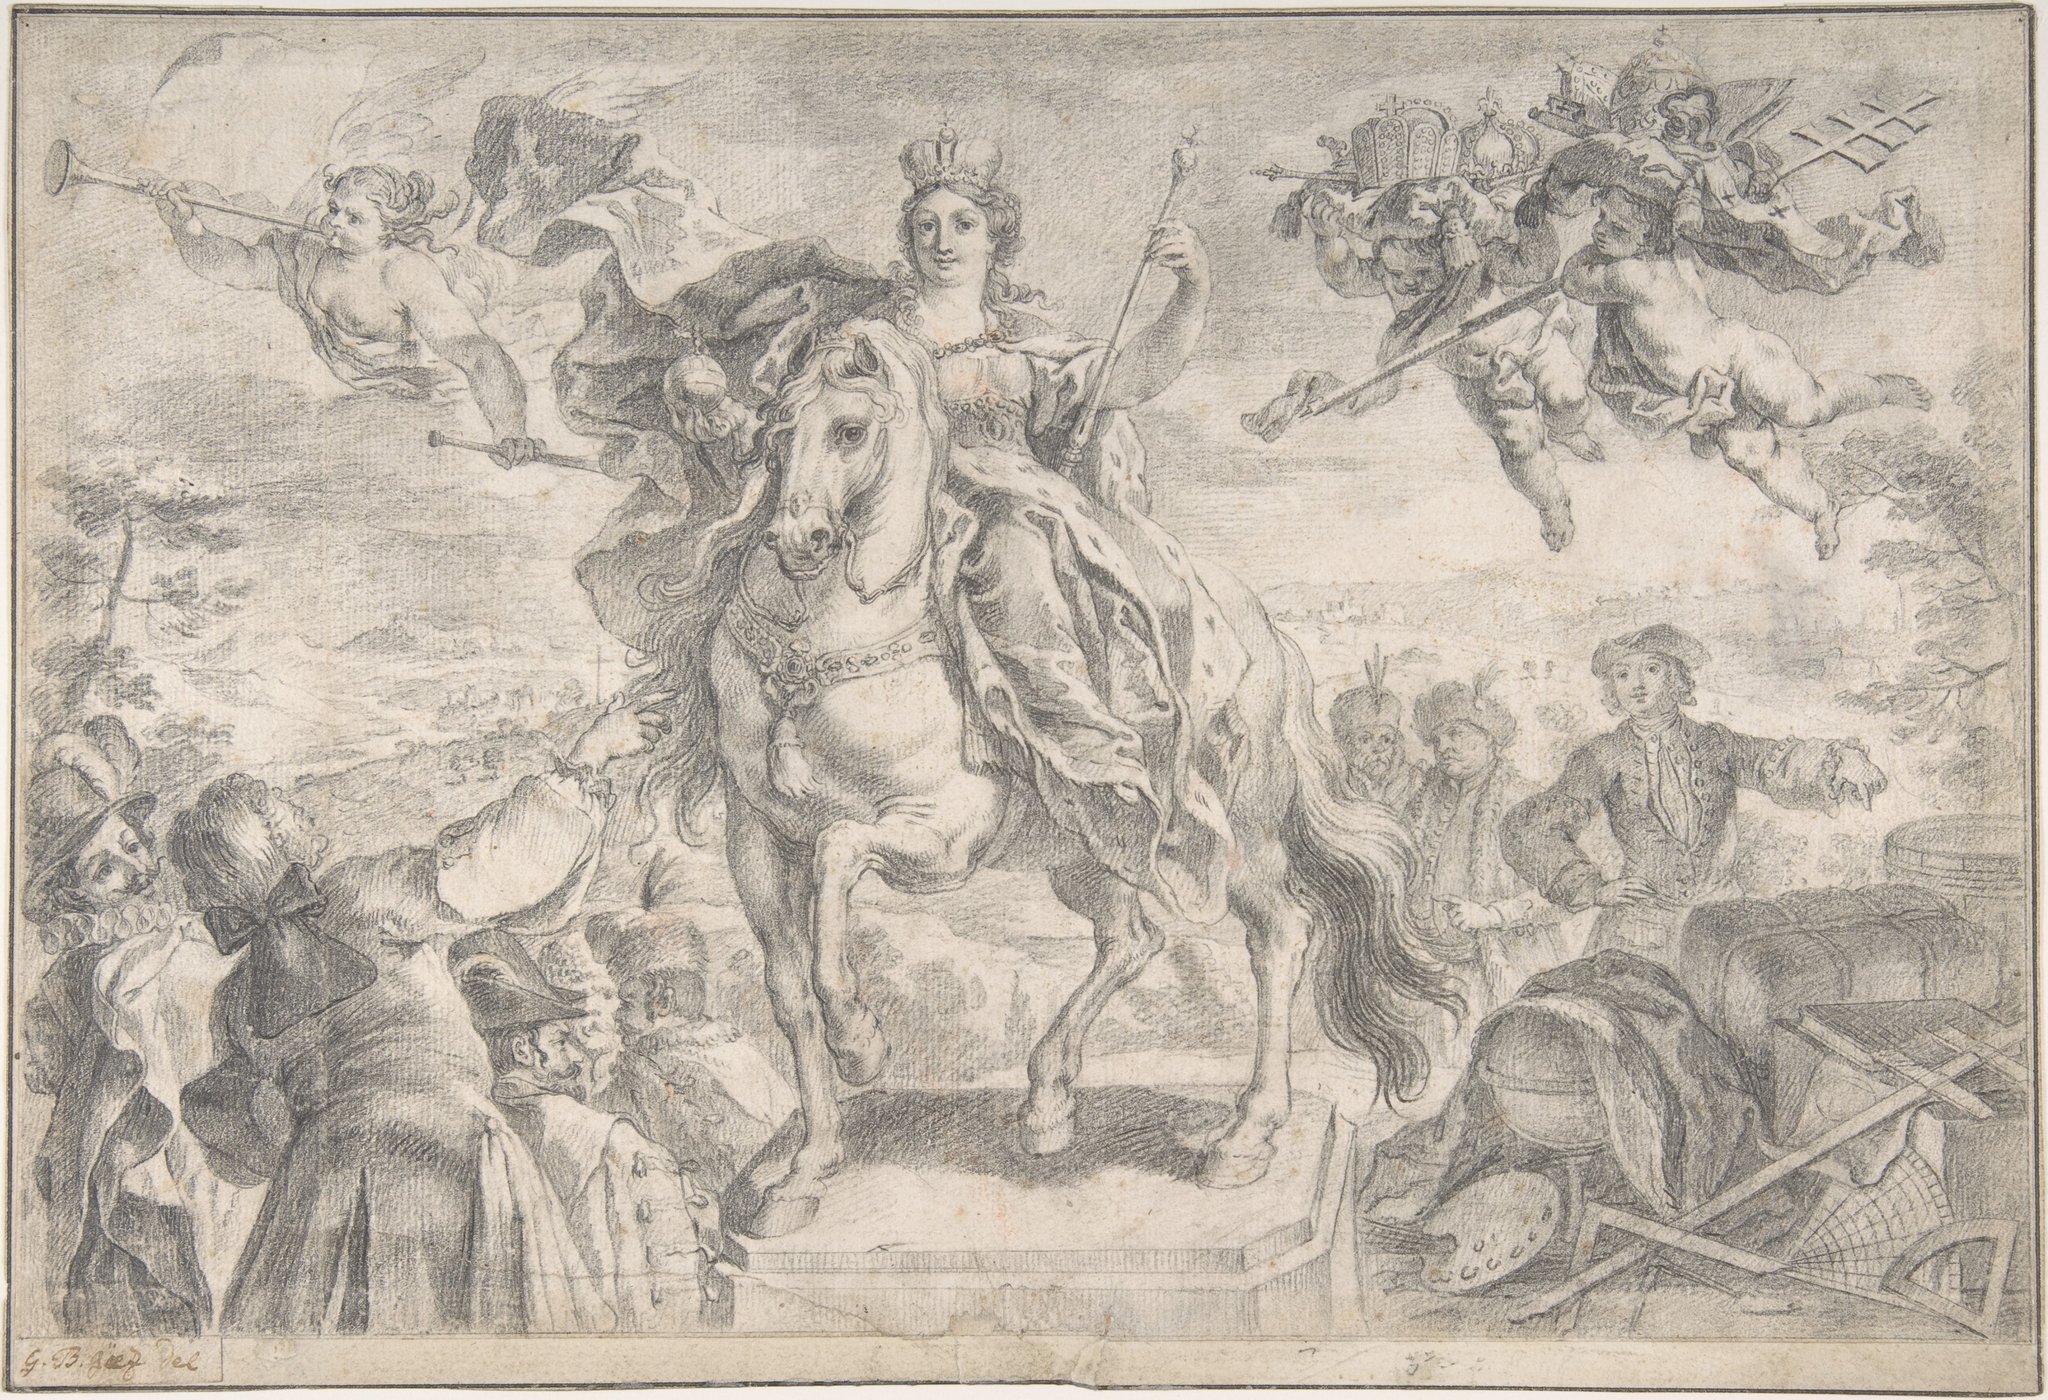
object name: drawing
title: Allegory of Europe, from the Four Continents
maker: gottfried bernhard goetz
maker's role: artist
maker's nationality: german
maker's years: 1708-1774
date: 1728-1774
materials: graphite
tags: musical instruments,men,women,horses